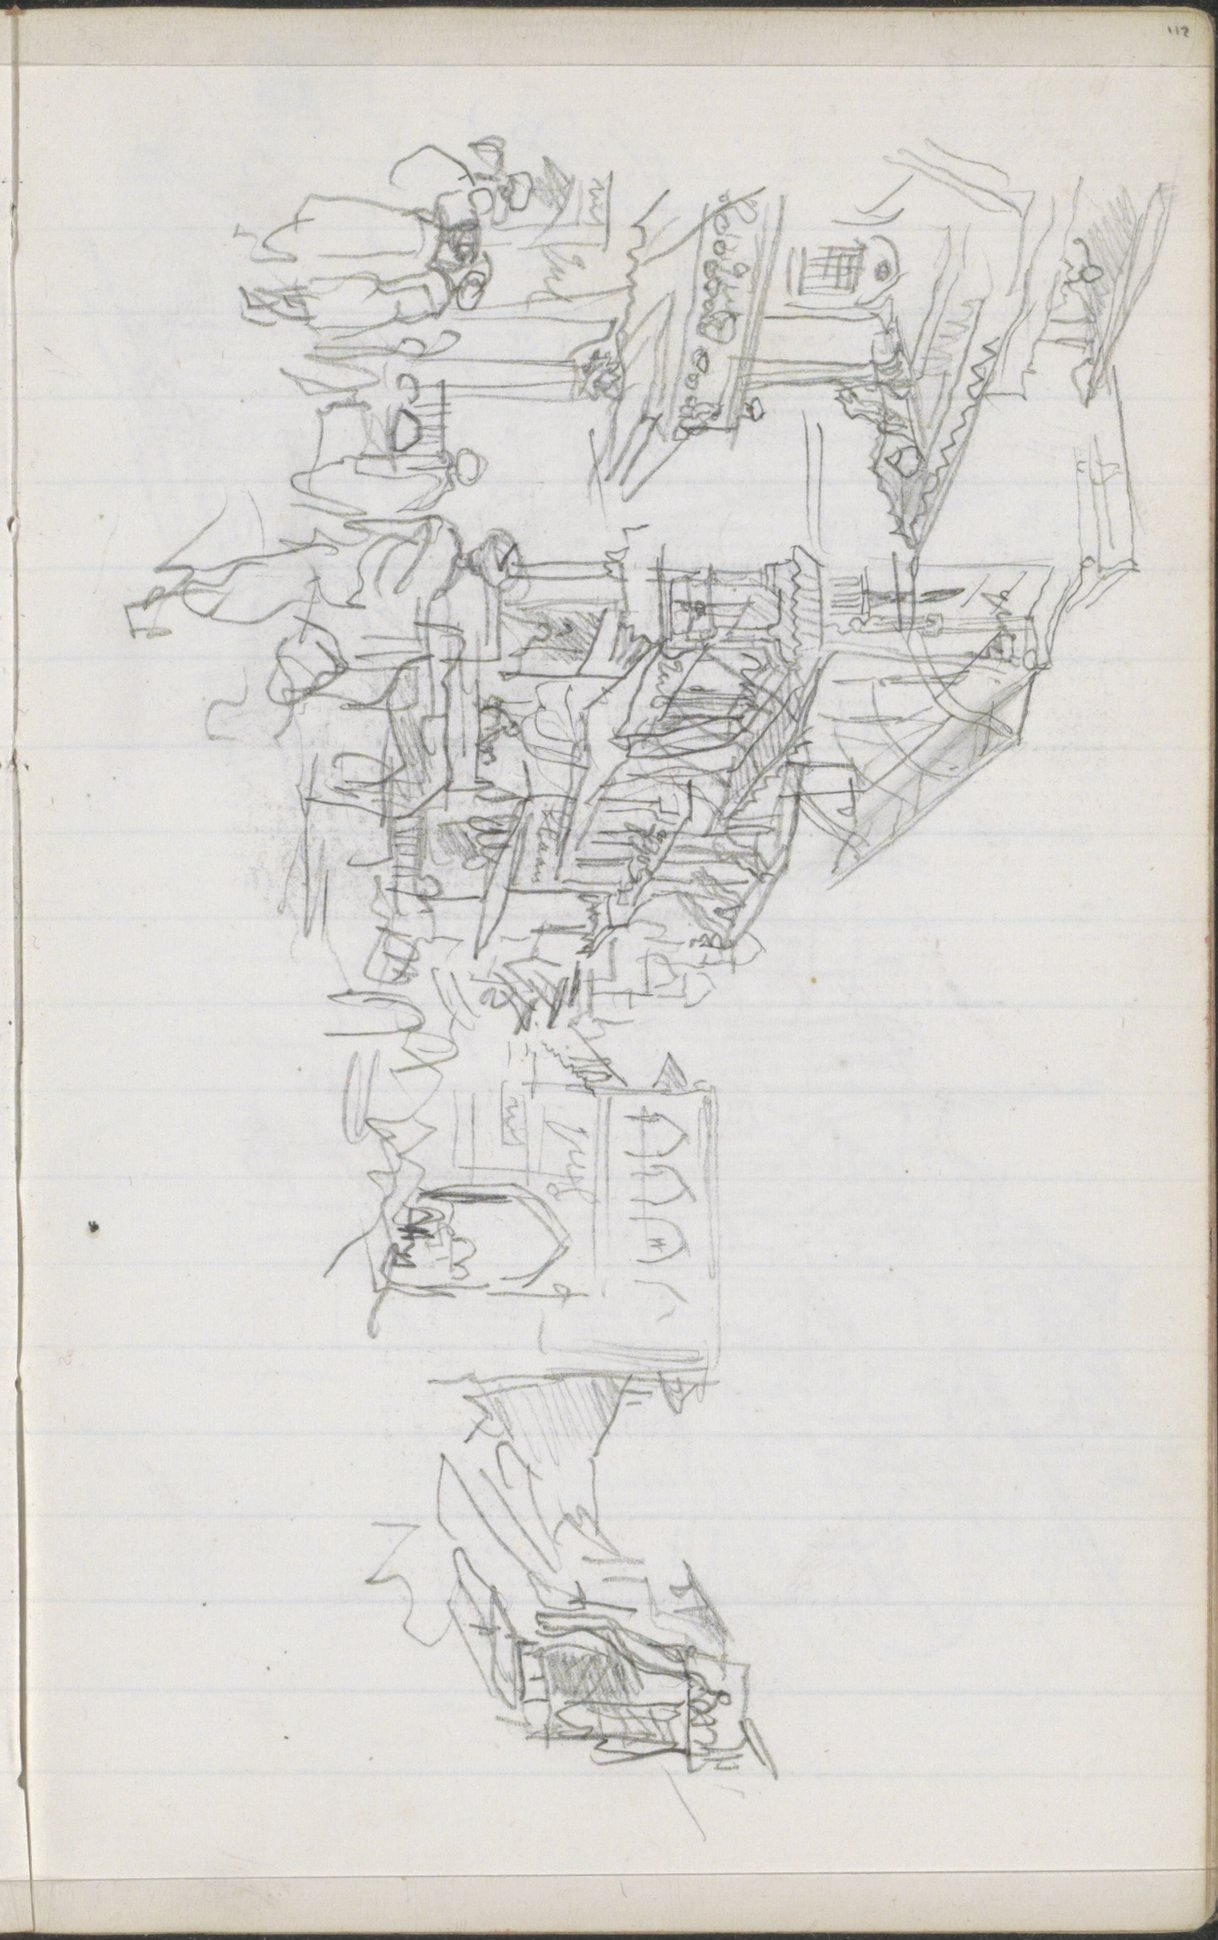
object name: sketchbook leaf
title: Straat met een poort in India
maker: marius bauer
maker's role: draughtsman, print maker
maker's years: 1867-1932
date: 1897-1898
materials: pencil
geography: india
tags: arch, archivolt ~ architecture, street (+ city(-scape) with figures, staffage)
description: Pagina 112 uit een schetsboek met 62 bladen.